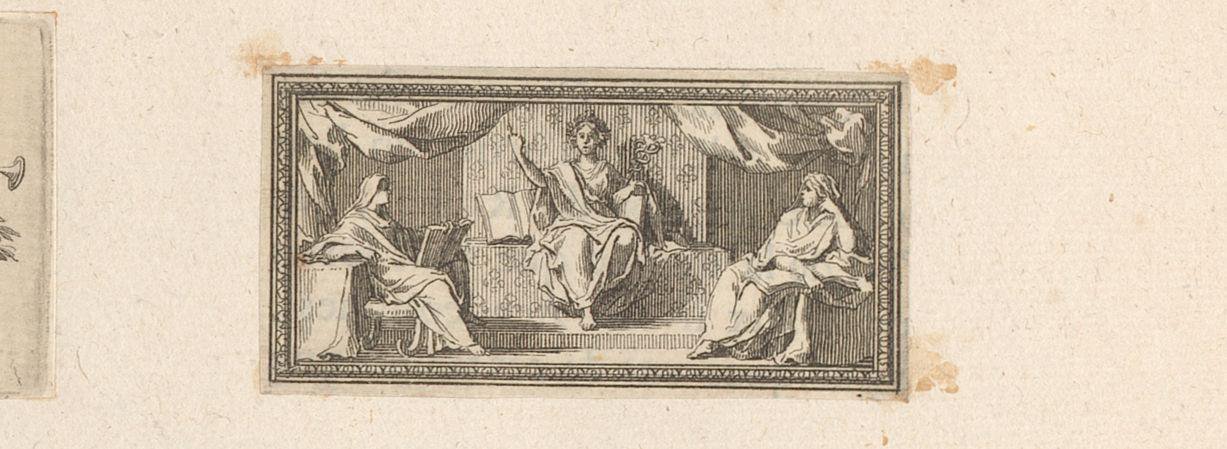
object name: book illustration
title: Vignet met Mercurius op de Troon der Welsprekendheid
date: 1680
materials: paper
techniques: etching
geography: paris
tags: hermes logios, mercury as god of eloquence, vignette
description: Prent gebruikt voor: Tallemant, Abbé Paul. Panegyriques et harangues à la louange du Roy (...). Parijs: Pierre Le Petit, 1680.